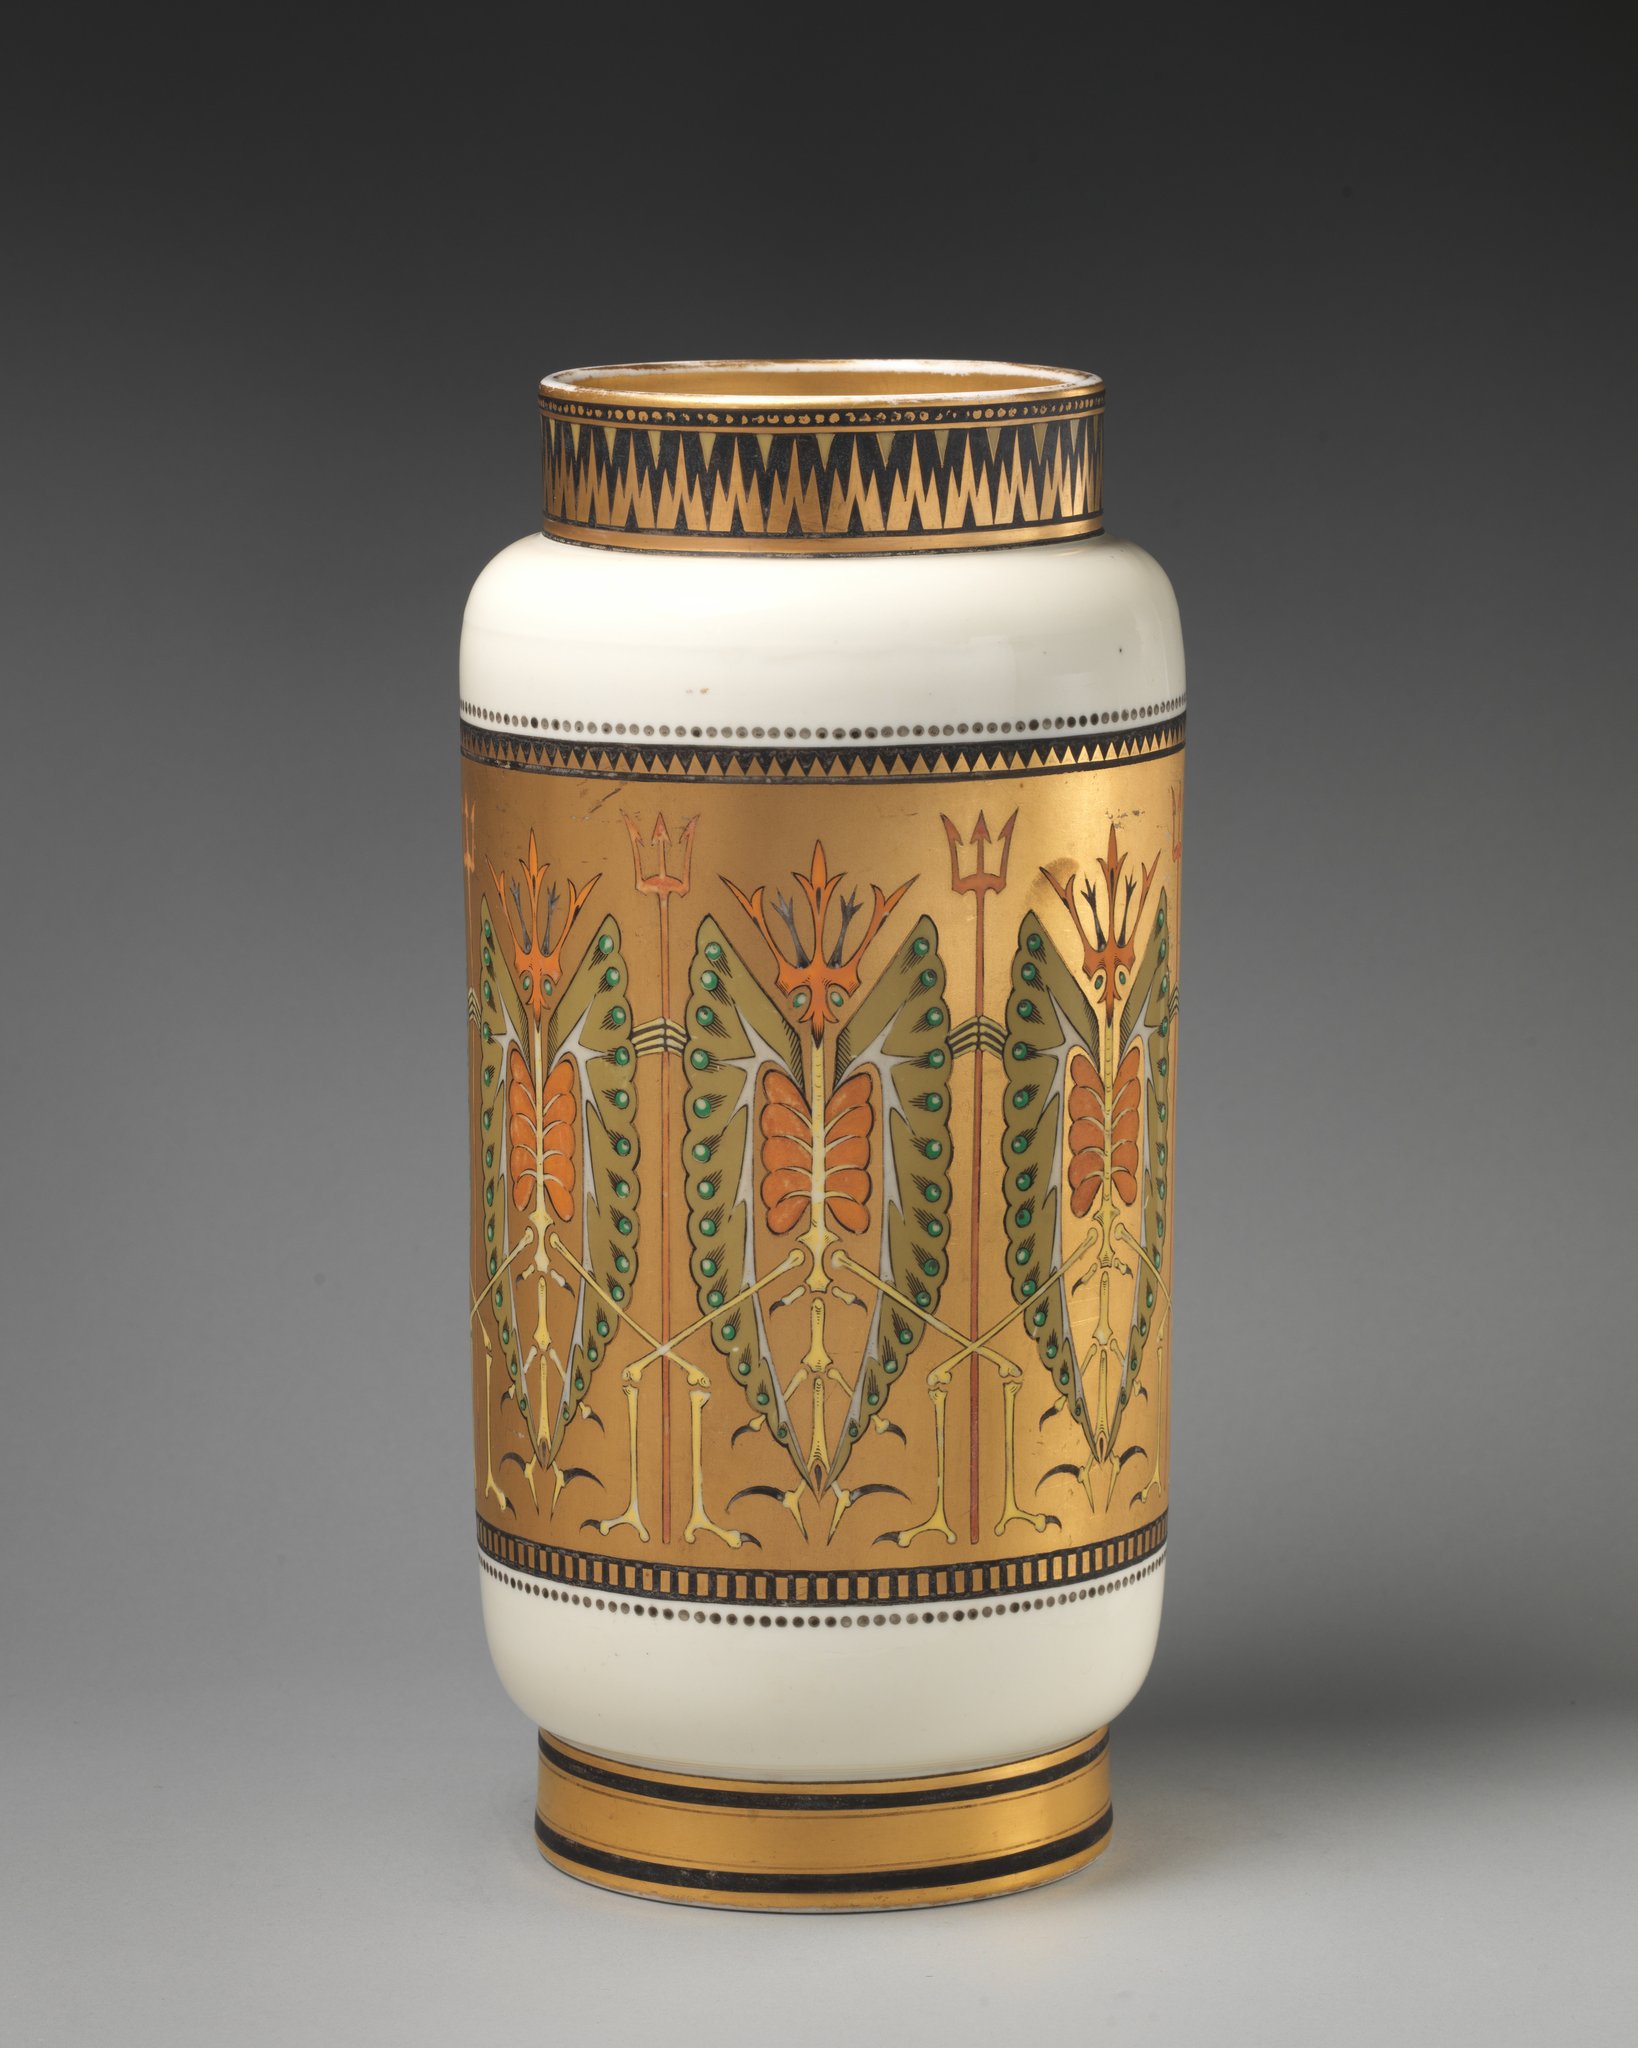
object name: vase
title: Vase with "Old Bogey" pattern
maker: christopher dresser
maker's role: designer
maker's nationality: british, scottish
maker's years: 1834-1904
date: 1867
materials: bone china